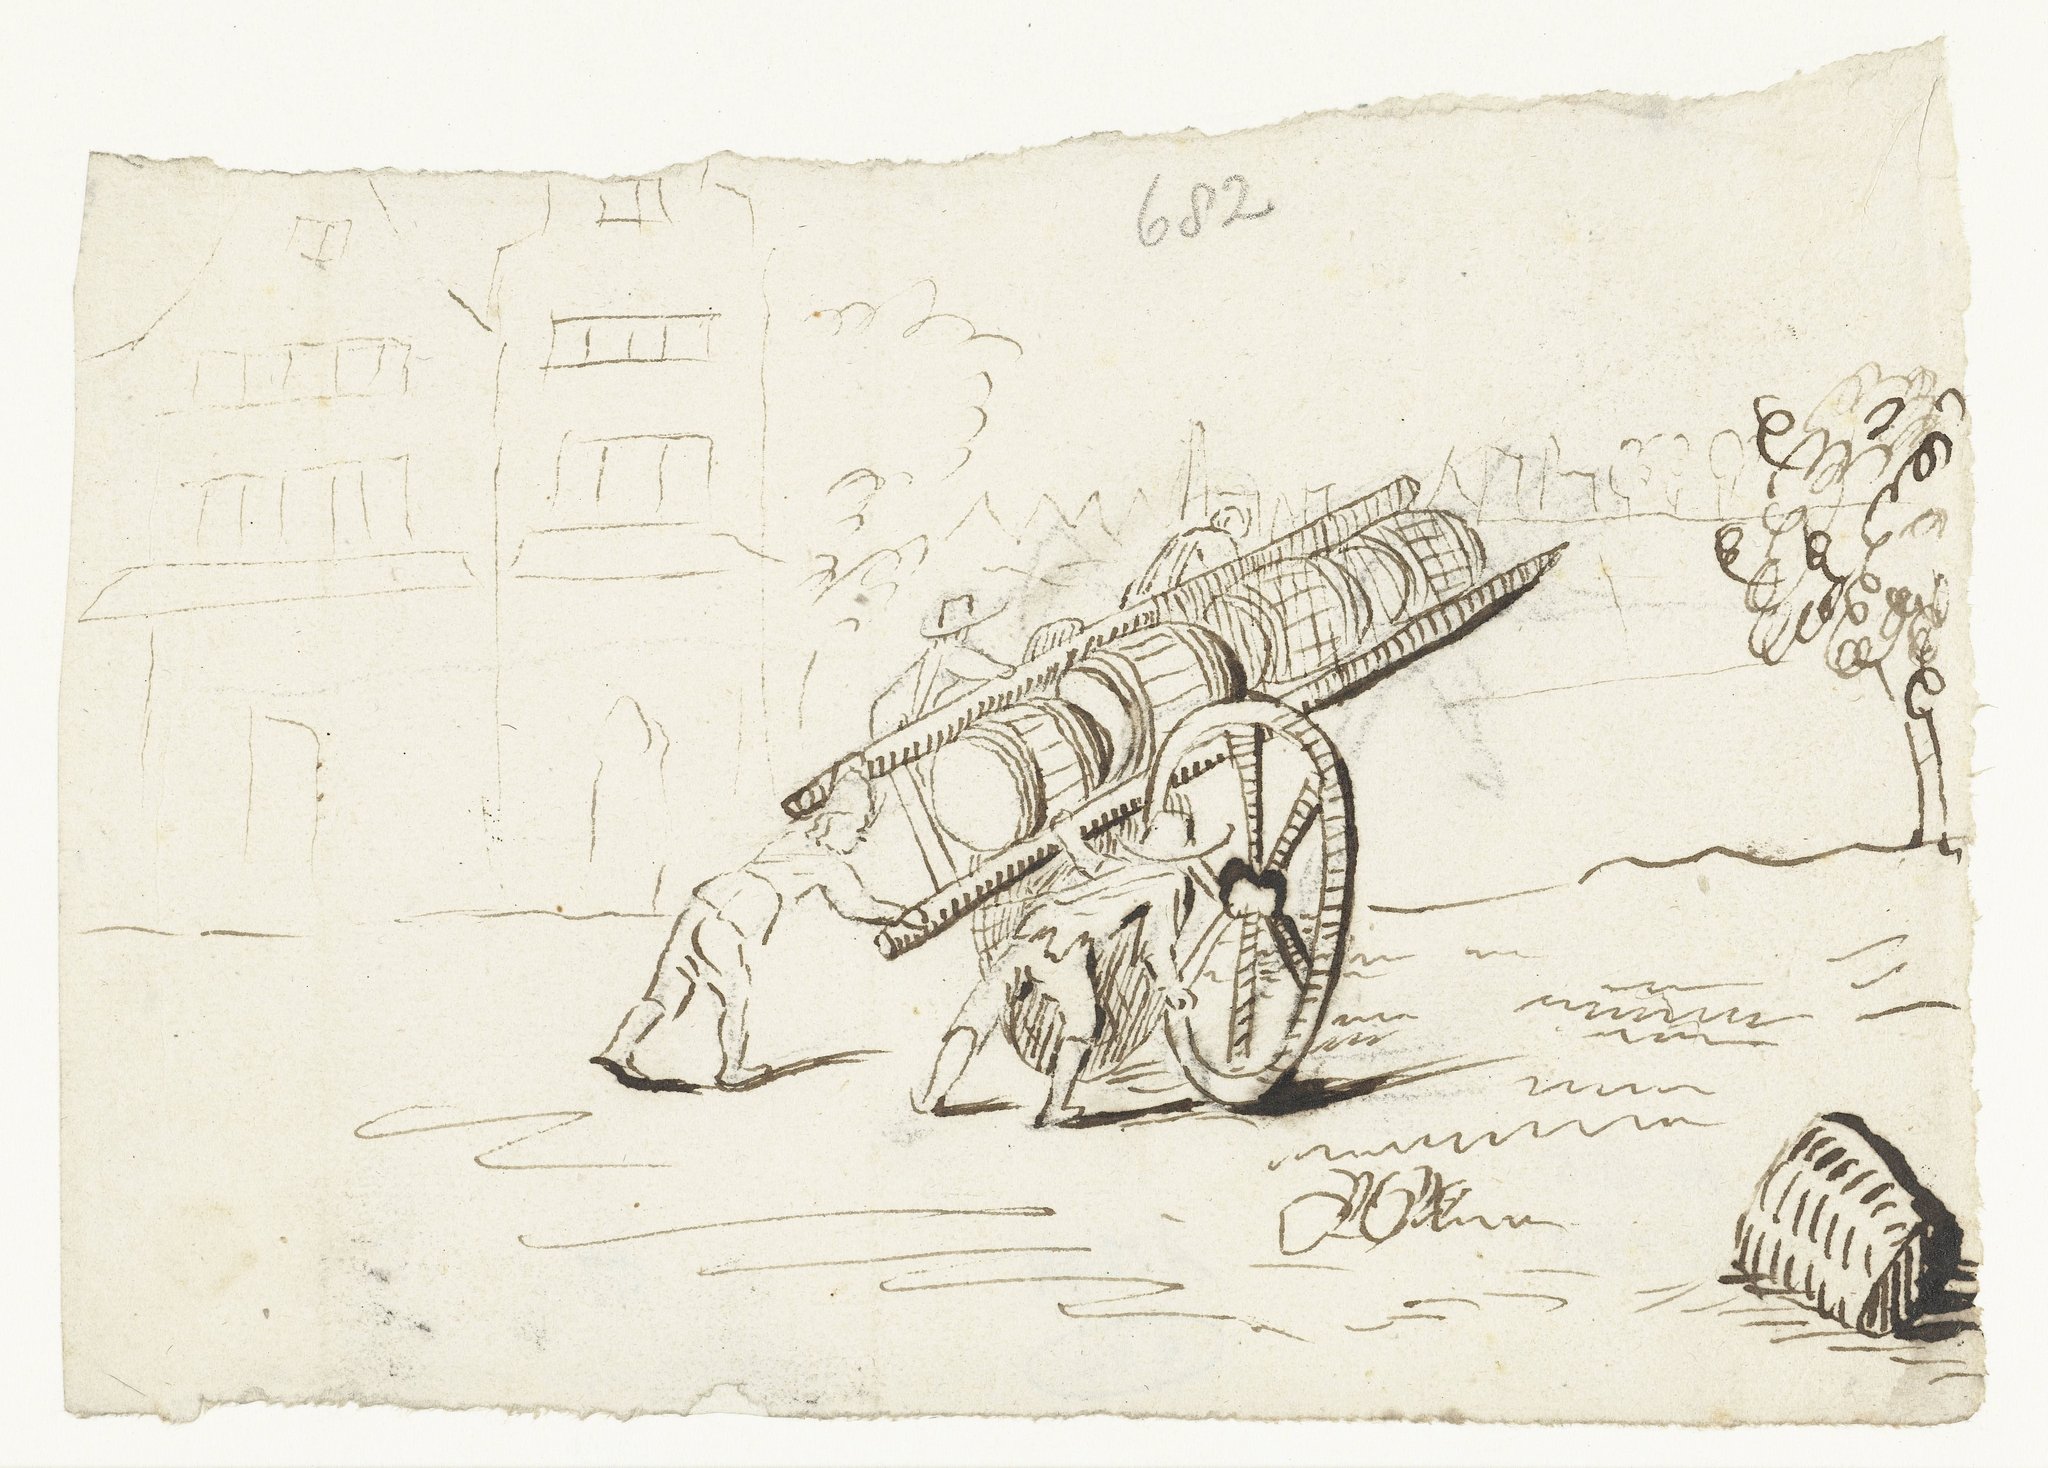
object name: drawing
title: Mannen duwen en kar beladen met vaten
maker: moses ter borch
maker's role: draughtsman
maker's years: 1645-1667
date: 1656-1657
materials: chalk, ink, paper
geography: zwolle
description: Maakt deel uit van een groep tekeningen (cat.nr. M 8 t/m M 20) toegeschreven aan Moses ter Borch.